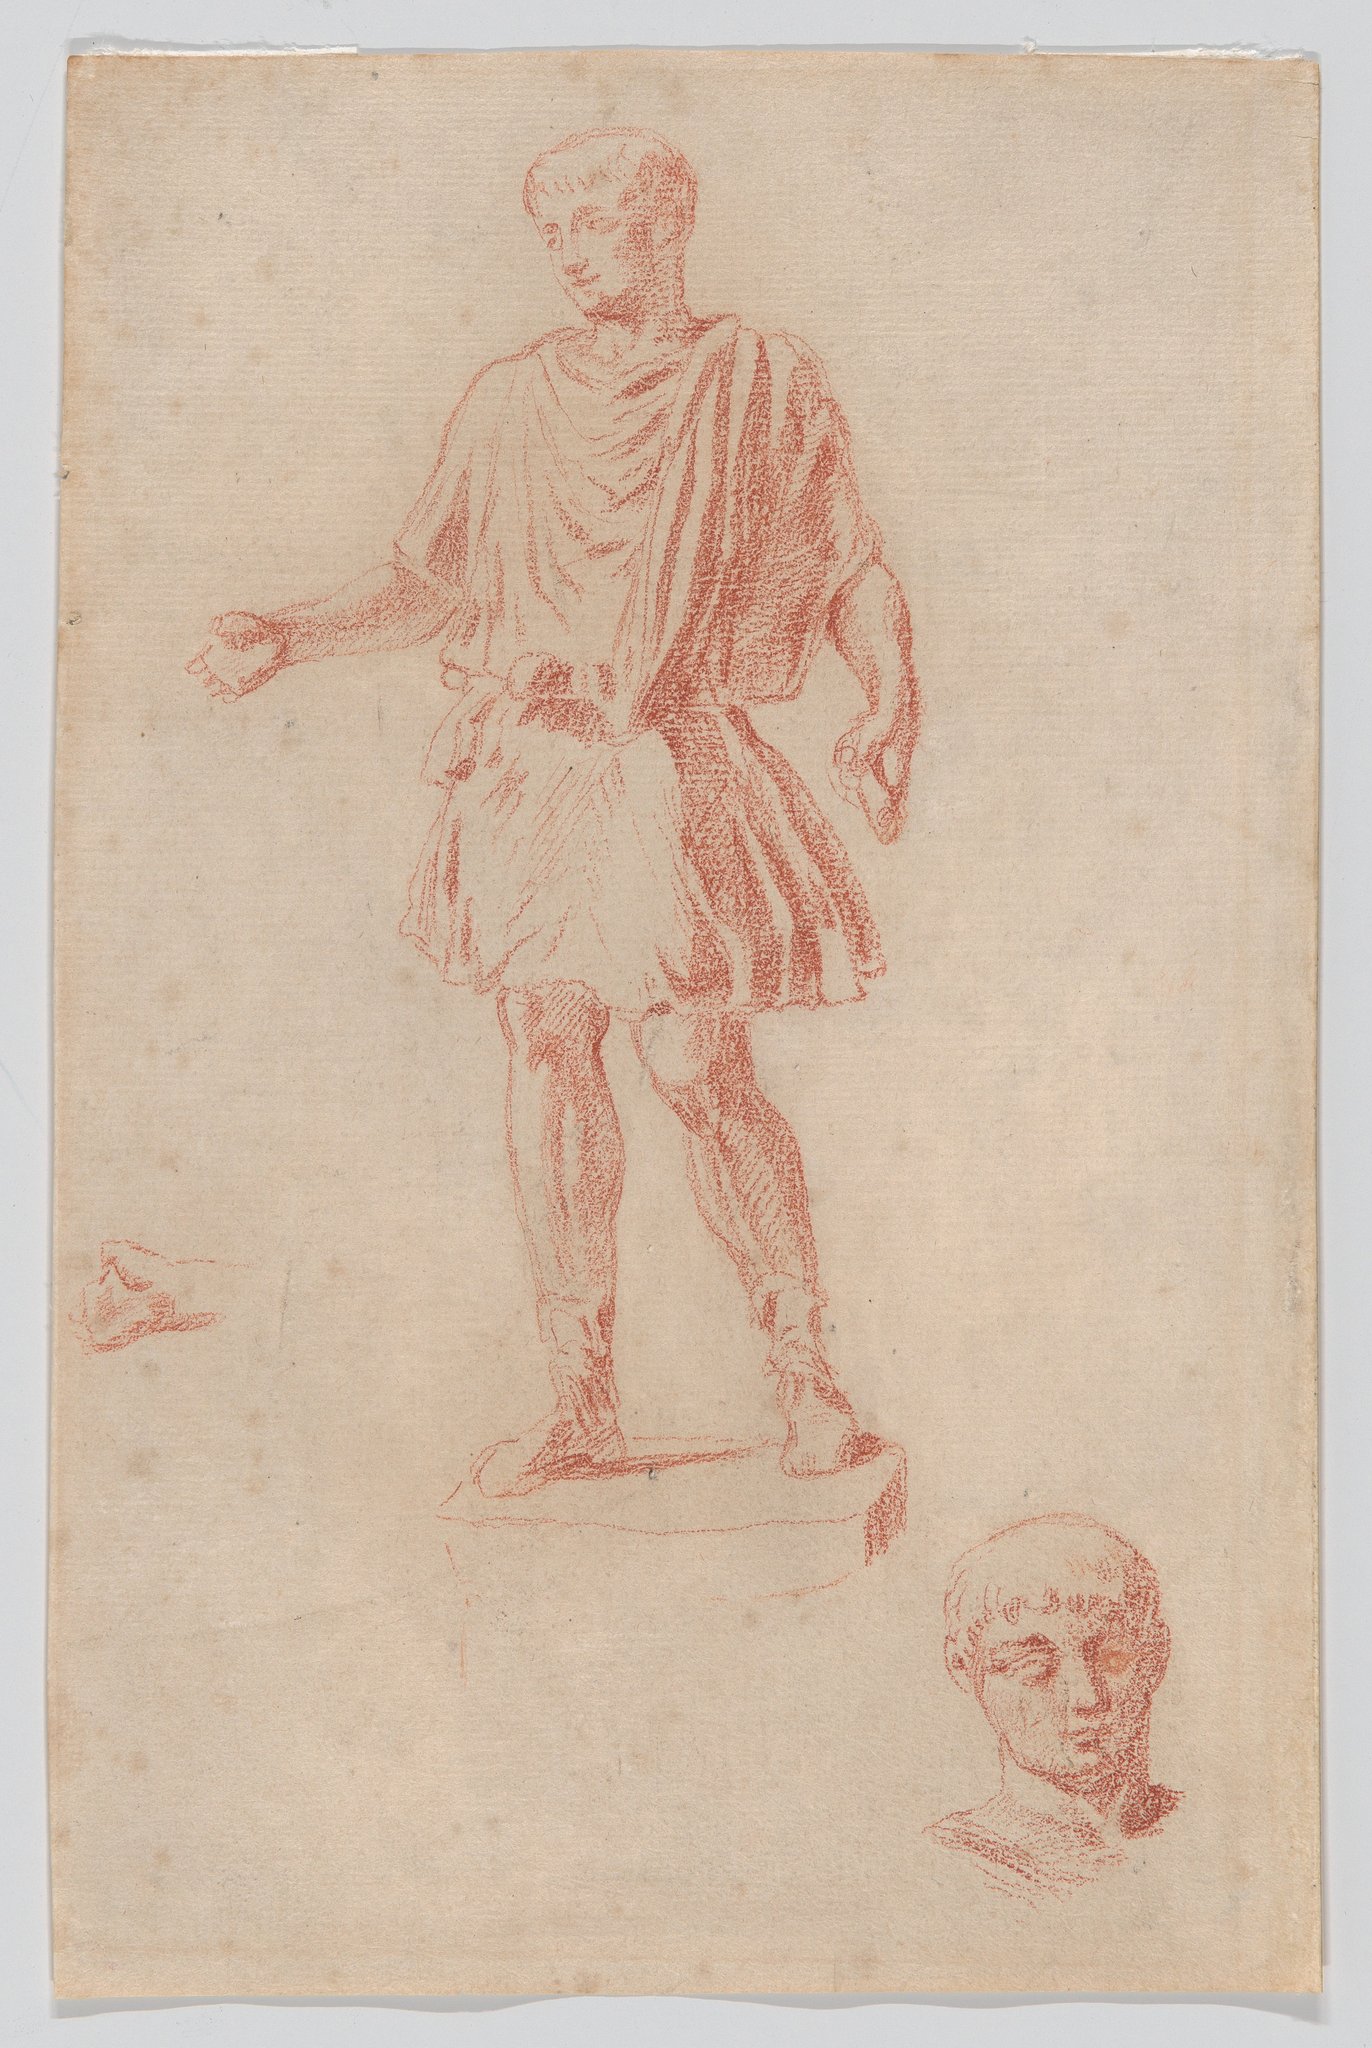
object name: drawing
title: Study of a Classical Sculpture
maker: eugène delacroix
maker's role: artist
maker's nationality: french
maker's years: 1798-1863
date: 1845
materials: chalk